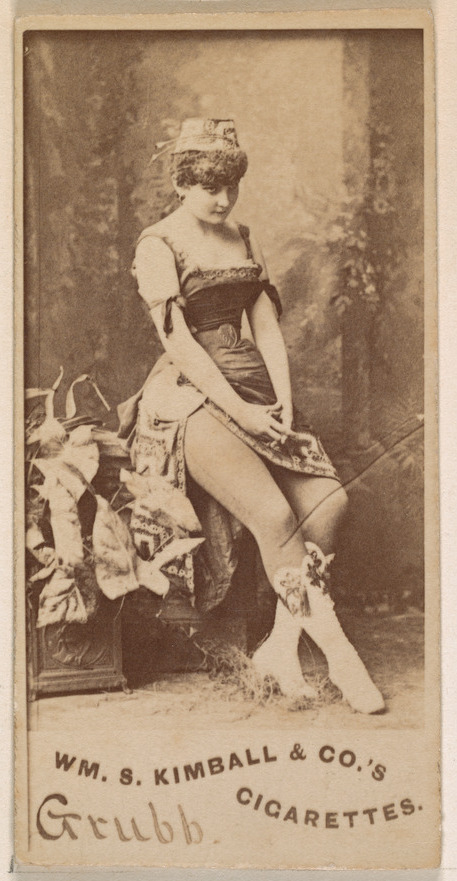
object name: photograph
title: Lillian Grubb, from the Actresses series (N203) issued by Wm. S. Kimball & Co.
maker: william s. kimball & company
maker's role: publisher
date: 1889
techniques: color lithograph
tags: portraits,women,actresses